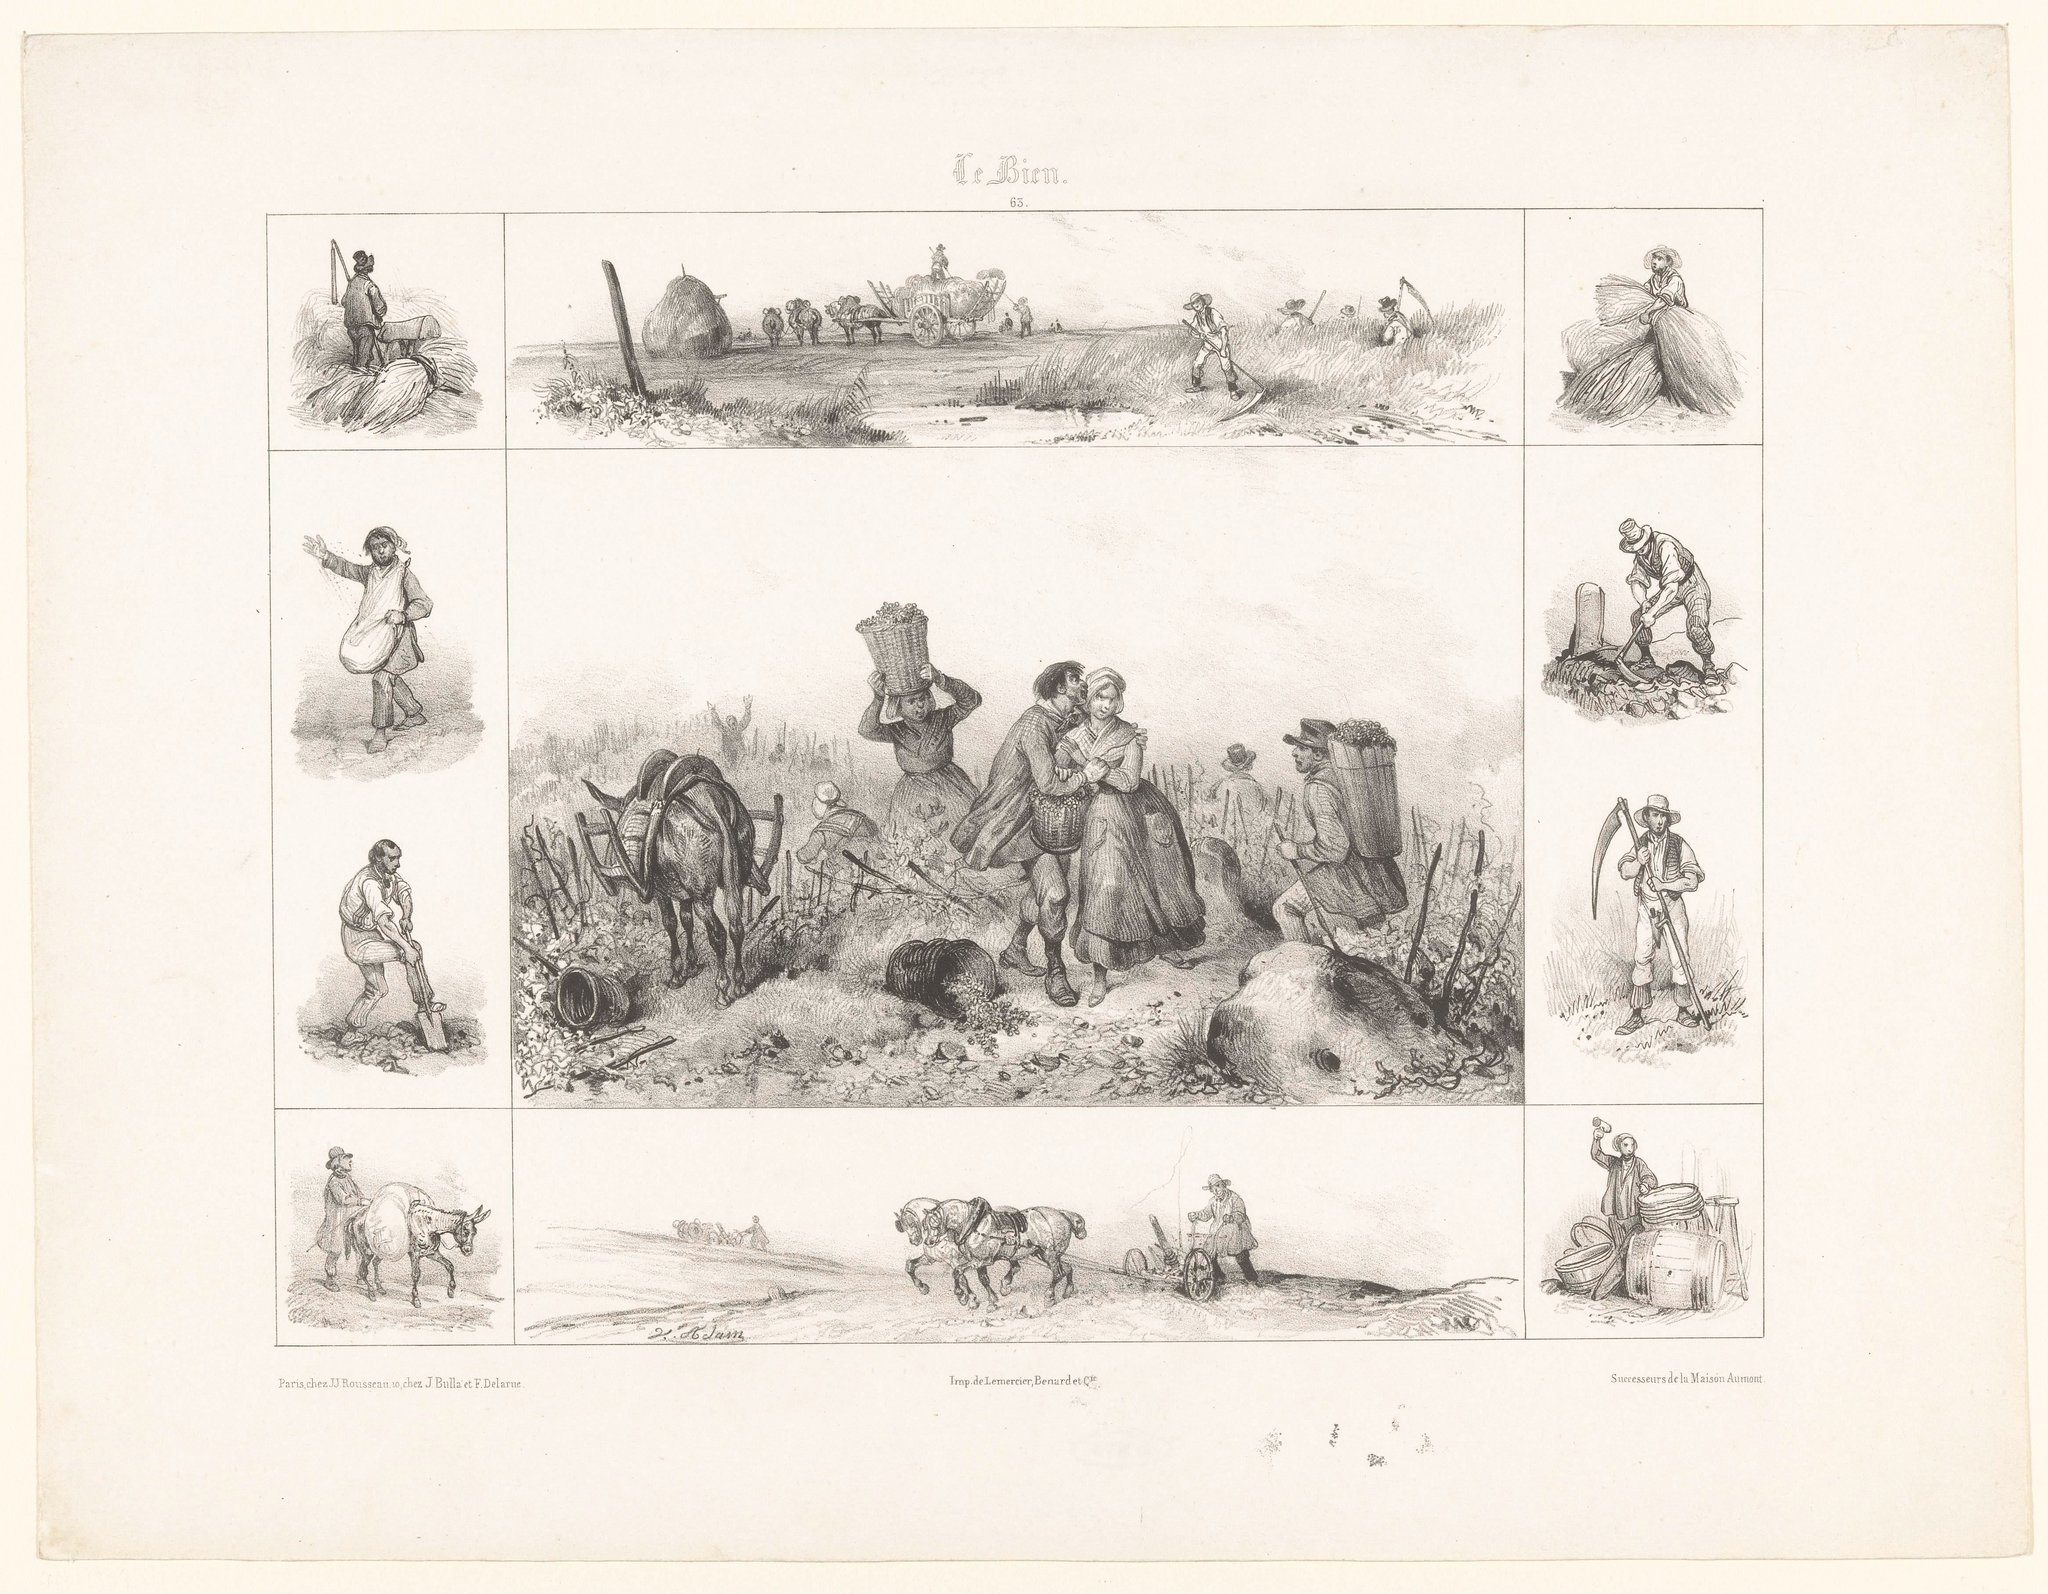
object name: print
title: Het goede en het kwade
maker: victor adam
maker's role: painter, print maker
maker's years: 1801-1866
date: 1839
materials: paper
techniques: lithograph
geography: paris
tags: good, right, farmers, farmers - aa - female farmer, farmer's wife, agriculture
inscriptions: collector's mark: Lugt 2228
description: Centraal een boerenpaar, met daar omheen acht voorstellingen van werk op het land.